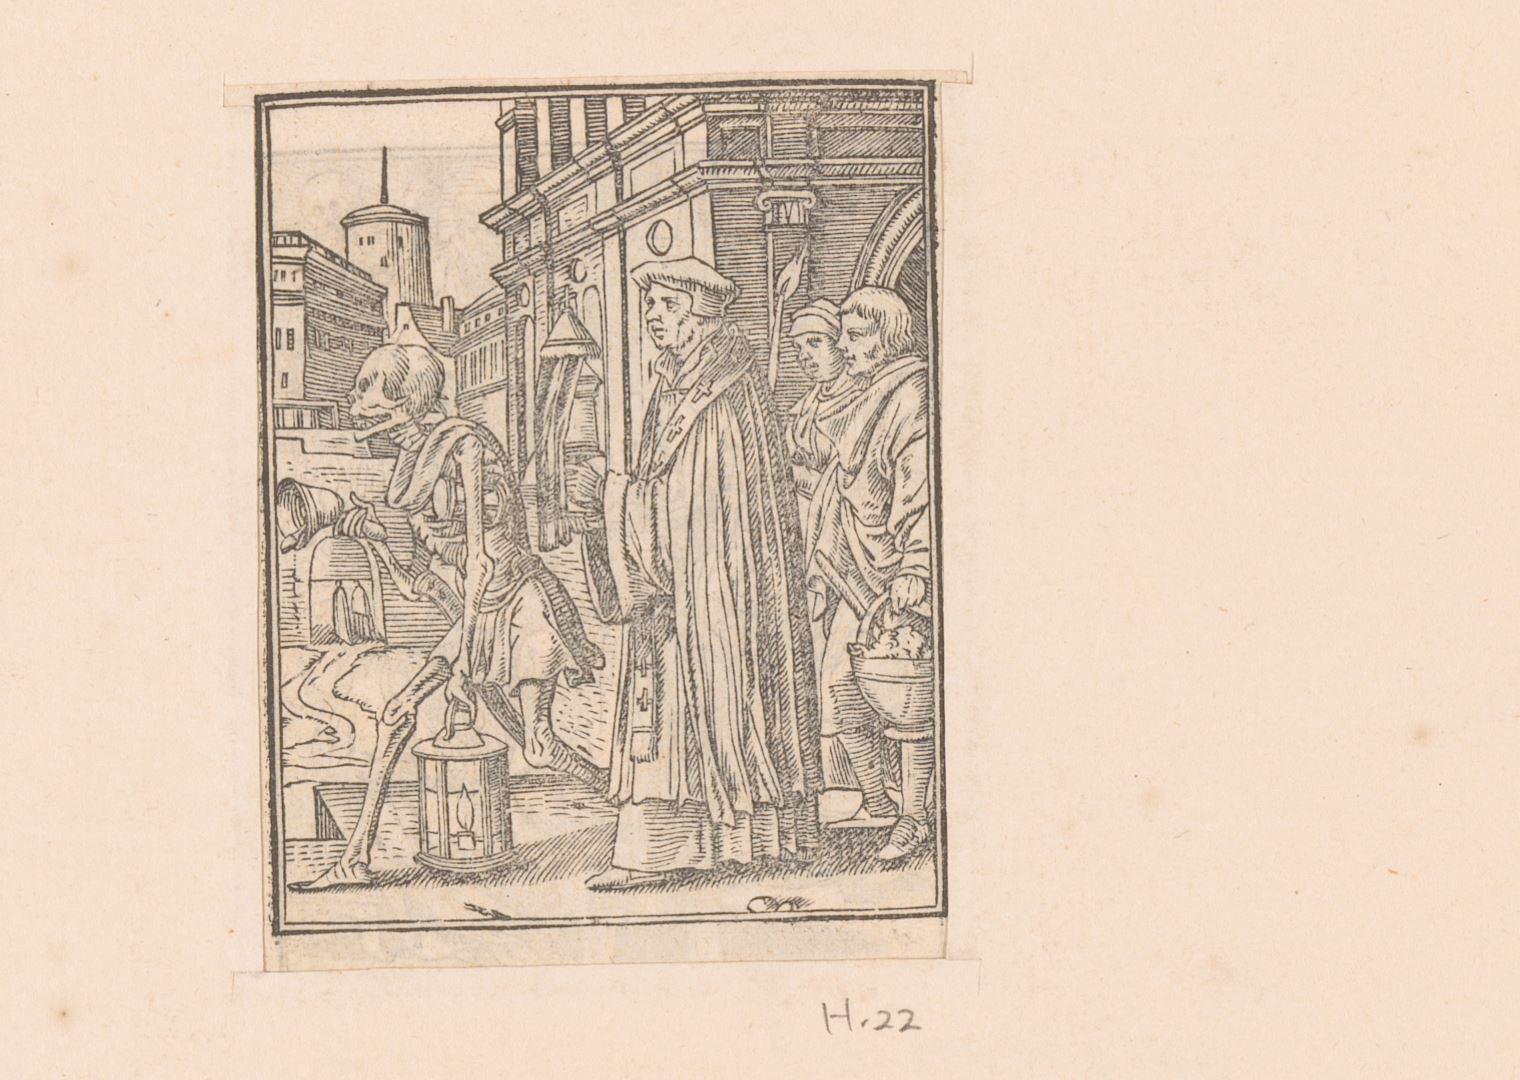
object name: book illustration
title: Kopieën naar Holbeins Dodendans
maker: Anonymous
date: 1547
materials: paper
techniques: woodcut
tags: dance of death; death together with one or more human beings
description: Kopie van een prent van Hans Holbein de jongere uit 1538, voor het eerst gepubliceerd in: Imagines mortis (...). Lyon: Johannes Frellon, 1547.